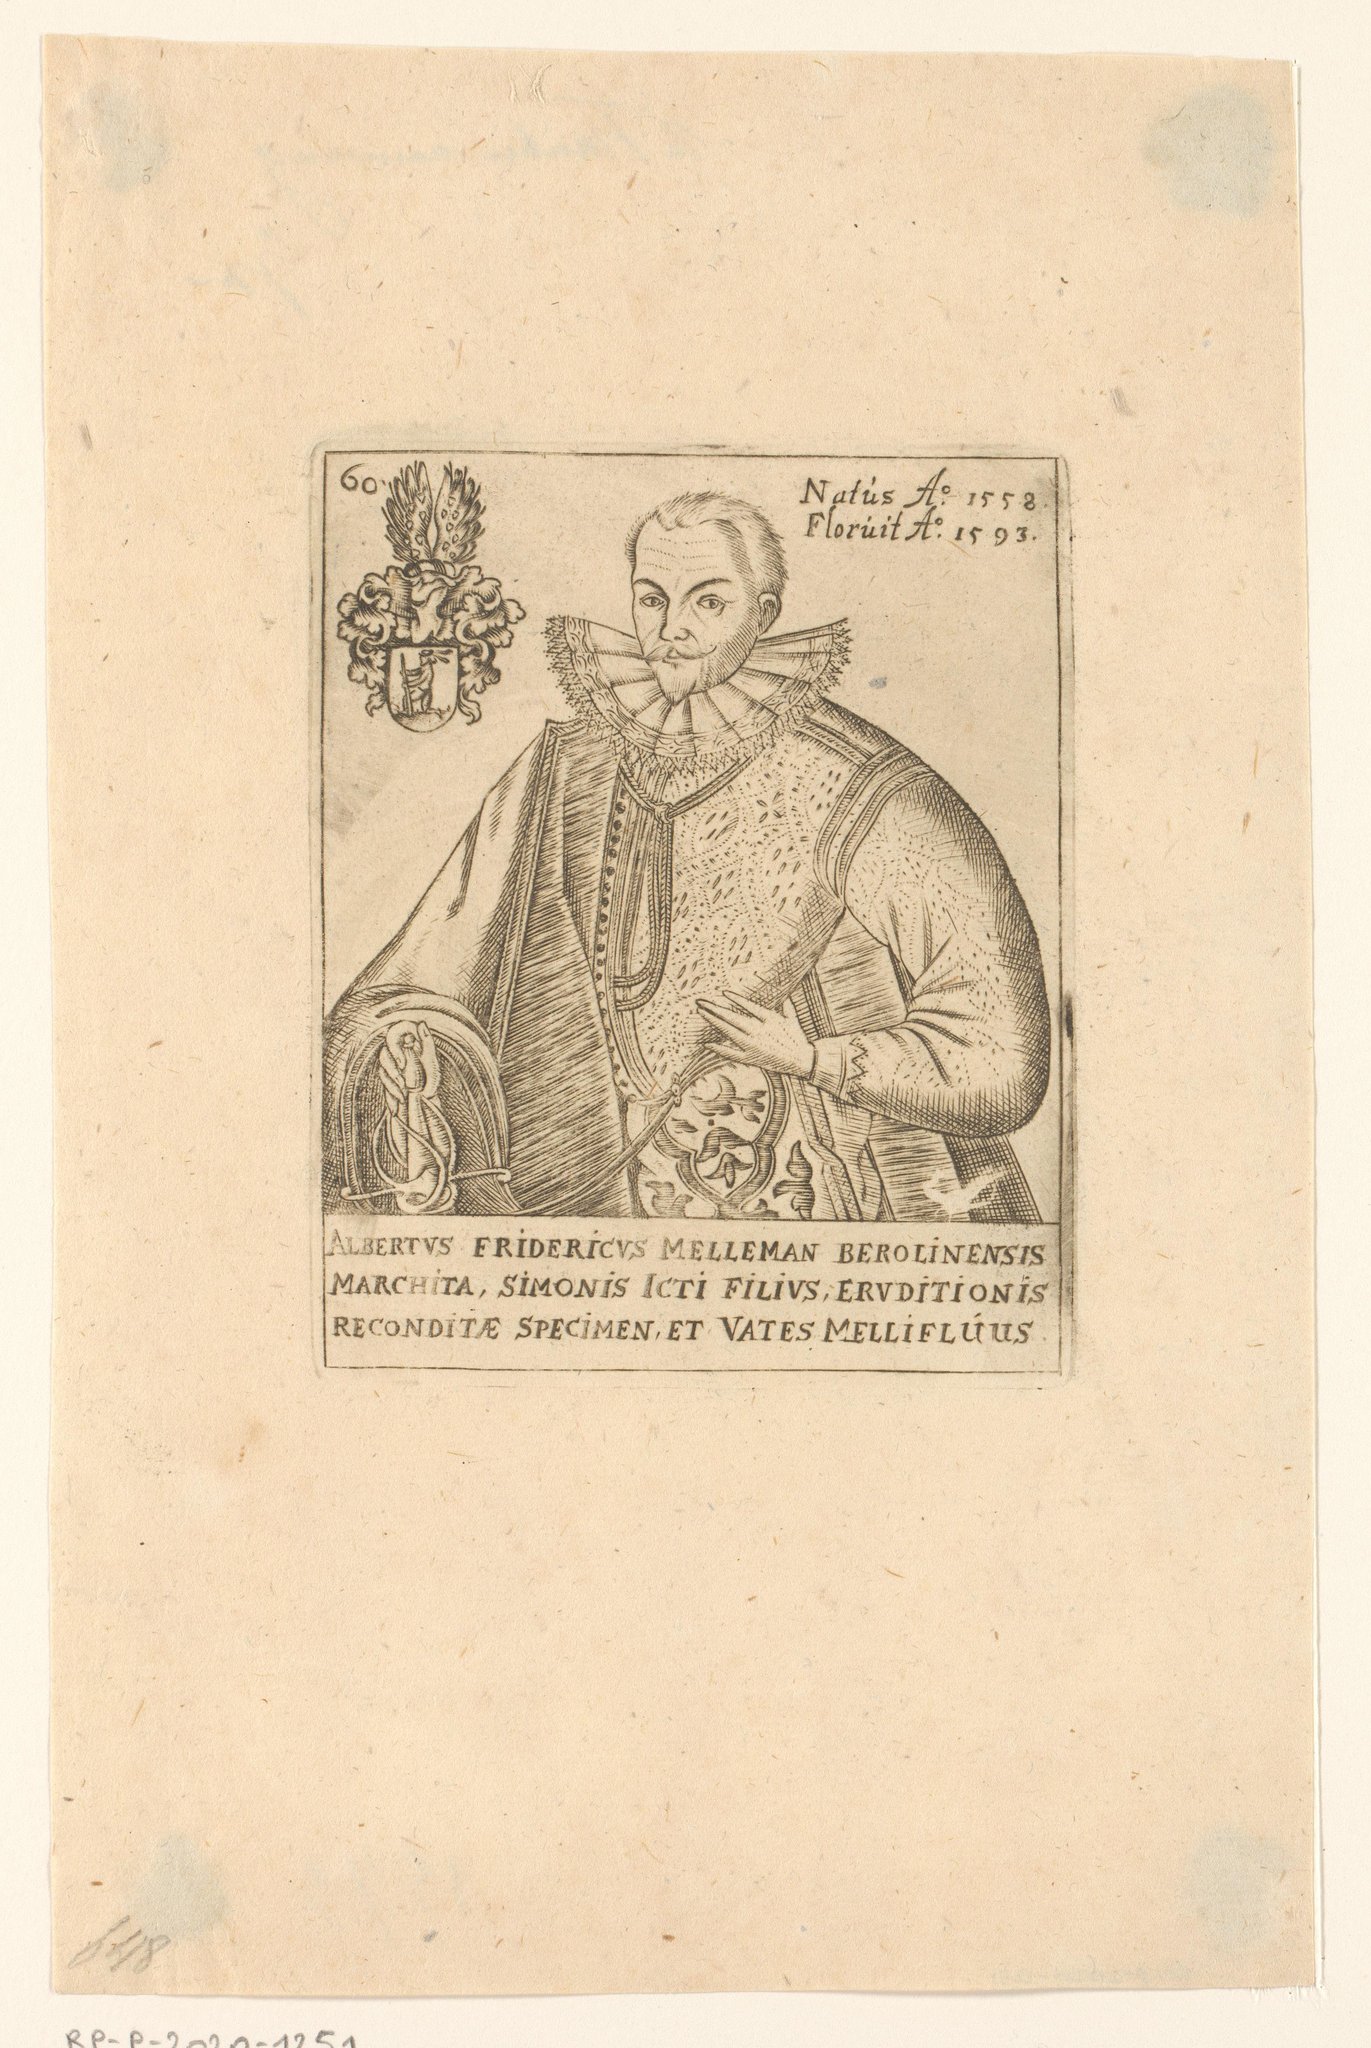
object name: print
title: Portretten van illustere mannen uit de omgeving van de mark Brandenburg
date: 1671-1751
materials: paper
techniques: engraving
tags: scholar, philosopher, historical persons, portrait of a writer, writer, poet, author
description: De prent is uitgegeven als onderdeel van een serie. Later is de prent mogelijk ook als boekillustratie gebruikt in: Küster, Georg Gottfried. Martin Friedrich Seidels Bilder-Sammlung in welcher hundert, gröstentheils in der Mark Brandenburg (…). Berlijn: Buchladen bey der Real-Schule, 1751. Het is onduidelijk tot welke uitgave de huidige prent behoort.